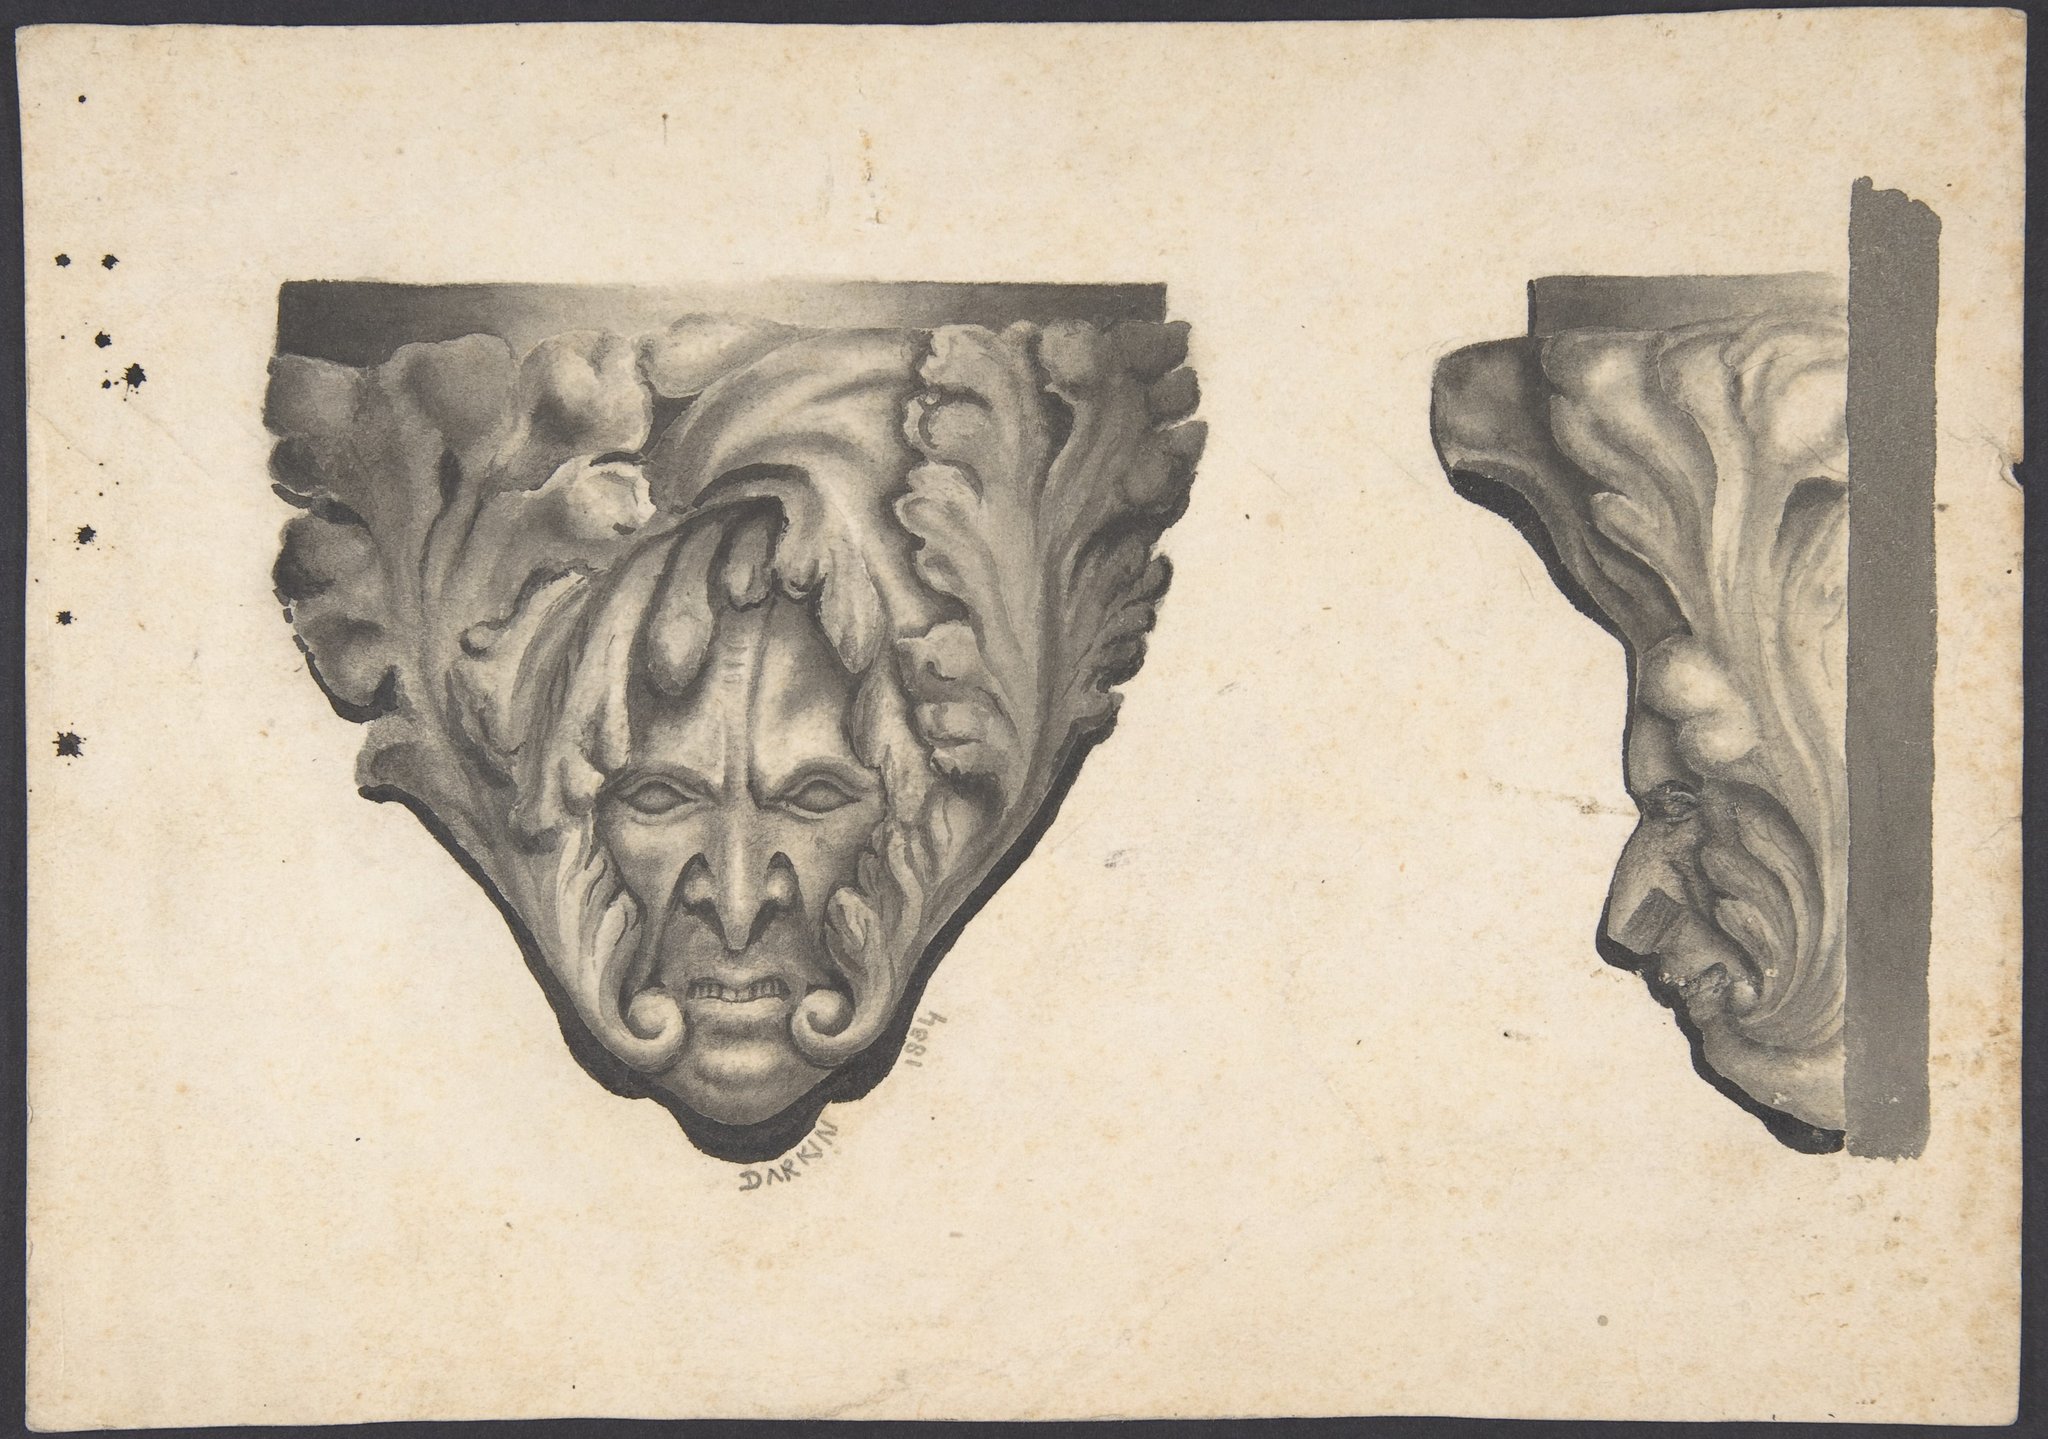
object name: drawing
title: Sketches of Carved Medieval Bosses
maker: john darkin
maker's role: artist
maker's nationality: british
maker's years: 1810-1874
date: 1834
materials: ink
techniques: brush, pen, wash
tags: faces,leaves